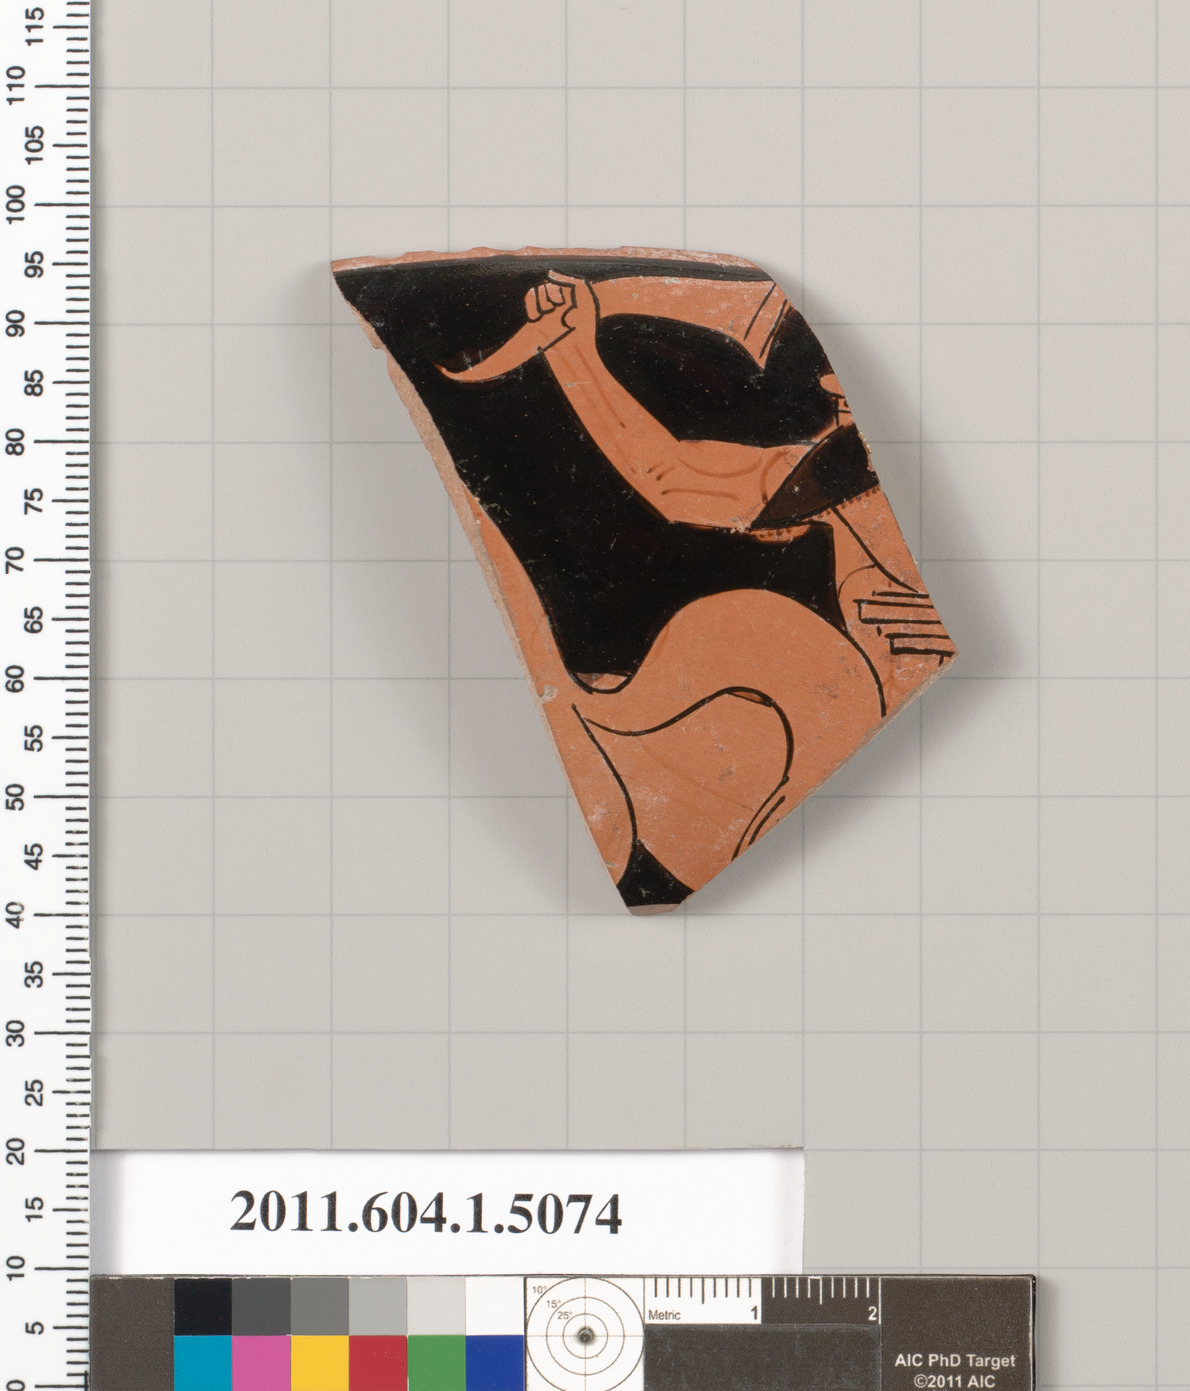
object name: kylix fragment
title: Terracotta rim fragment of a kylix (drinking cup)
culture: greek, attic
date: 510-500 BCE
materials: terracotta